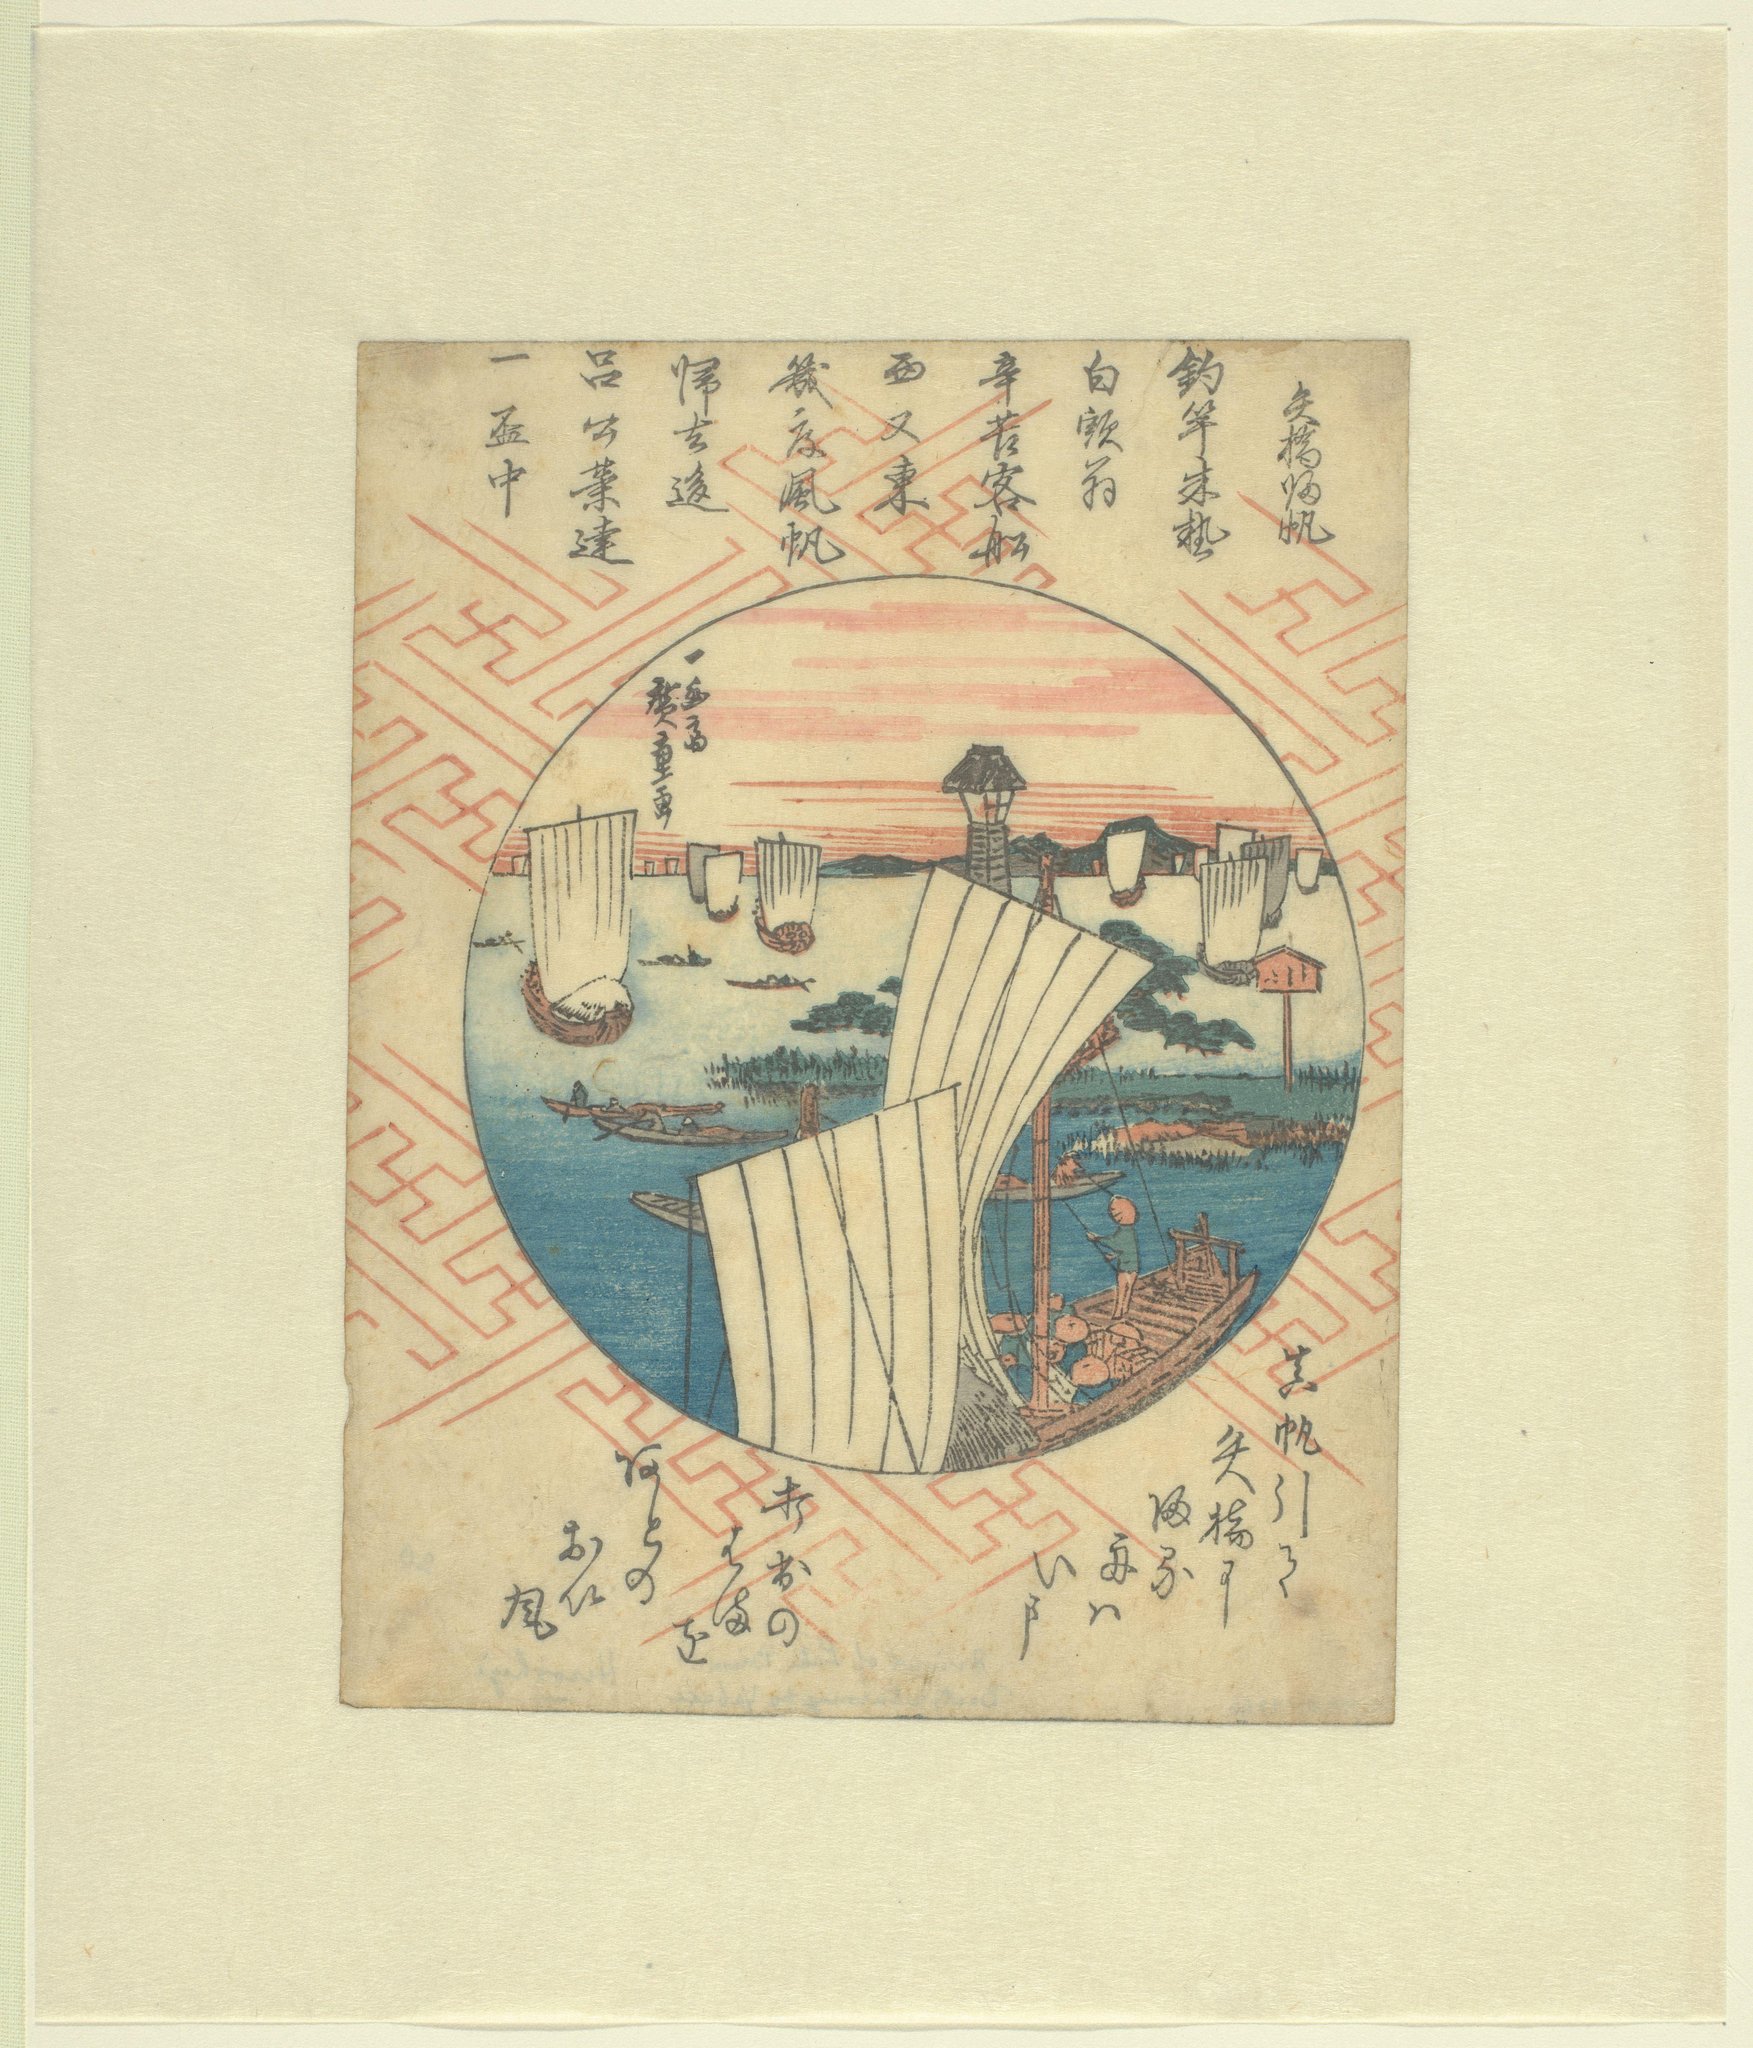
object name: print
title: Yabase kihan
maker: utagawa hiroshige (i)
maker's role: draughtsman, print maker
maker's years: 1797-1858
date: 1810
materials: paper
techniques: woodcut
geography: japan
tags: sailing-ship, sailing-boat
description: In een rond cartouche zijn bootjes afgebeeld, die terugkeren naar de haven van Yabase. Dit beeld is vaak gebruikt in de serie Acht gezichten van Ômi (Ômi hakkei). Met gedichten.